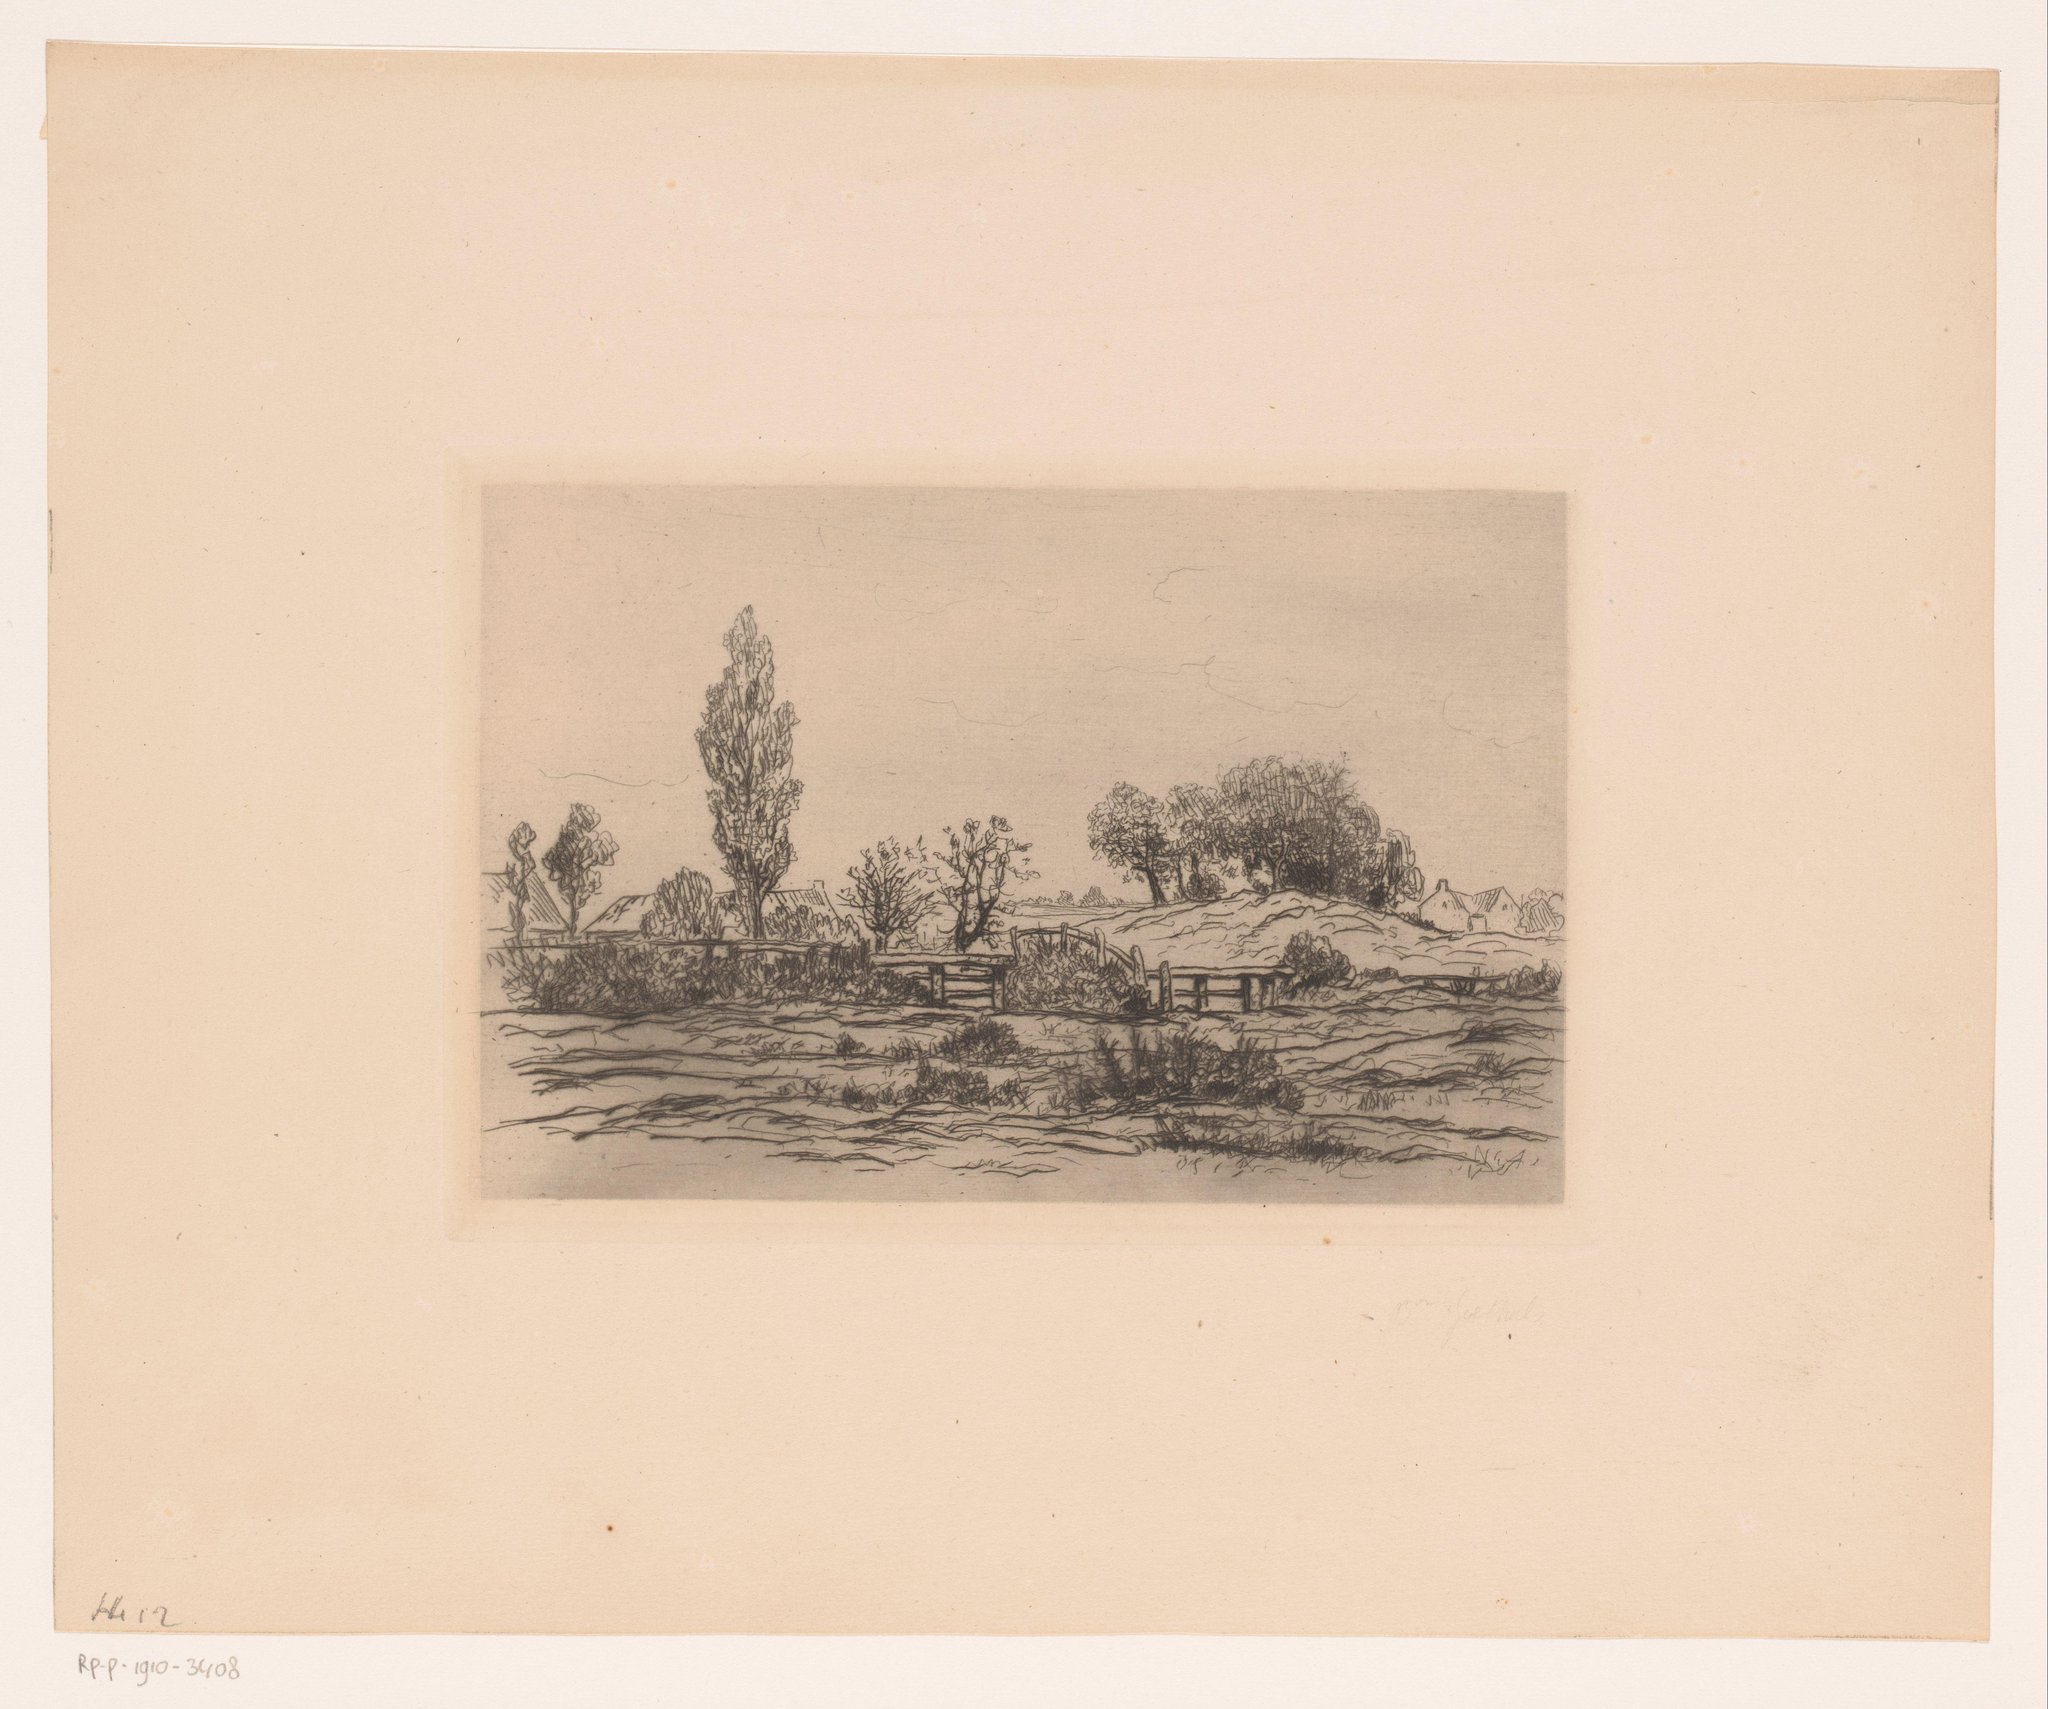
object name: print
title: Gezicht bij Nieuwpoort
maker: jules marie armand goethals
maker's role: print maker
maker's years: 1844-1902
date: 1854-1879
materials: paper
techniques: etching, intaglio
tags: landscapes, farm (building)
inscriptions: collector's mark: Lugt 2228